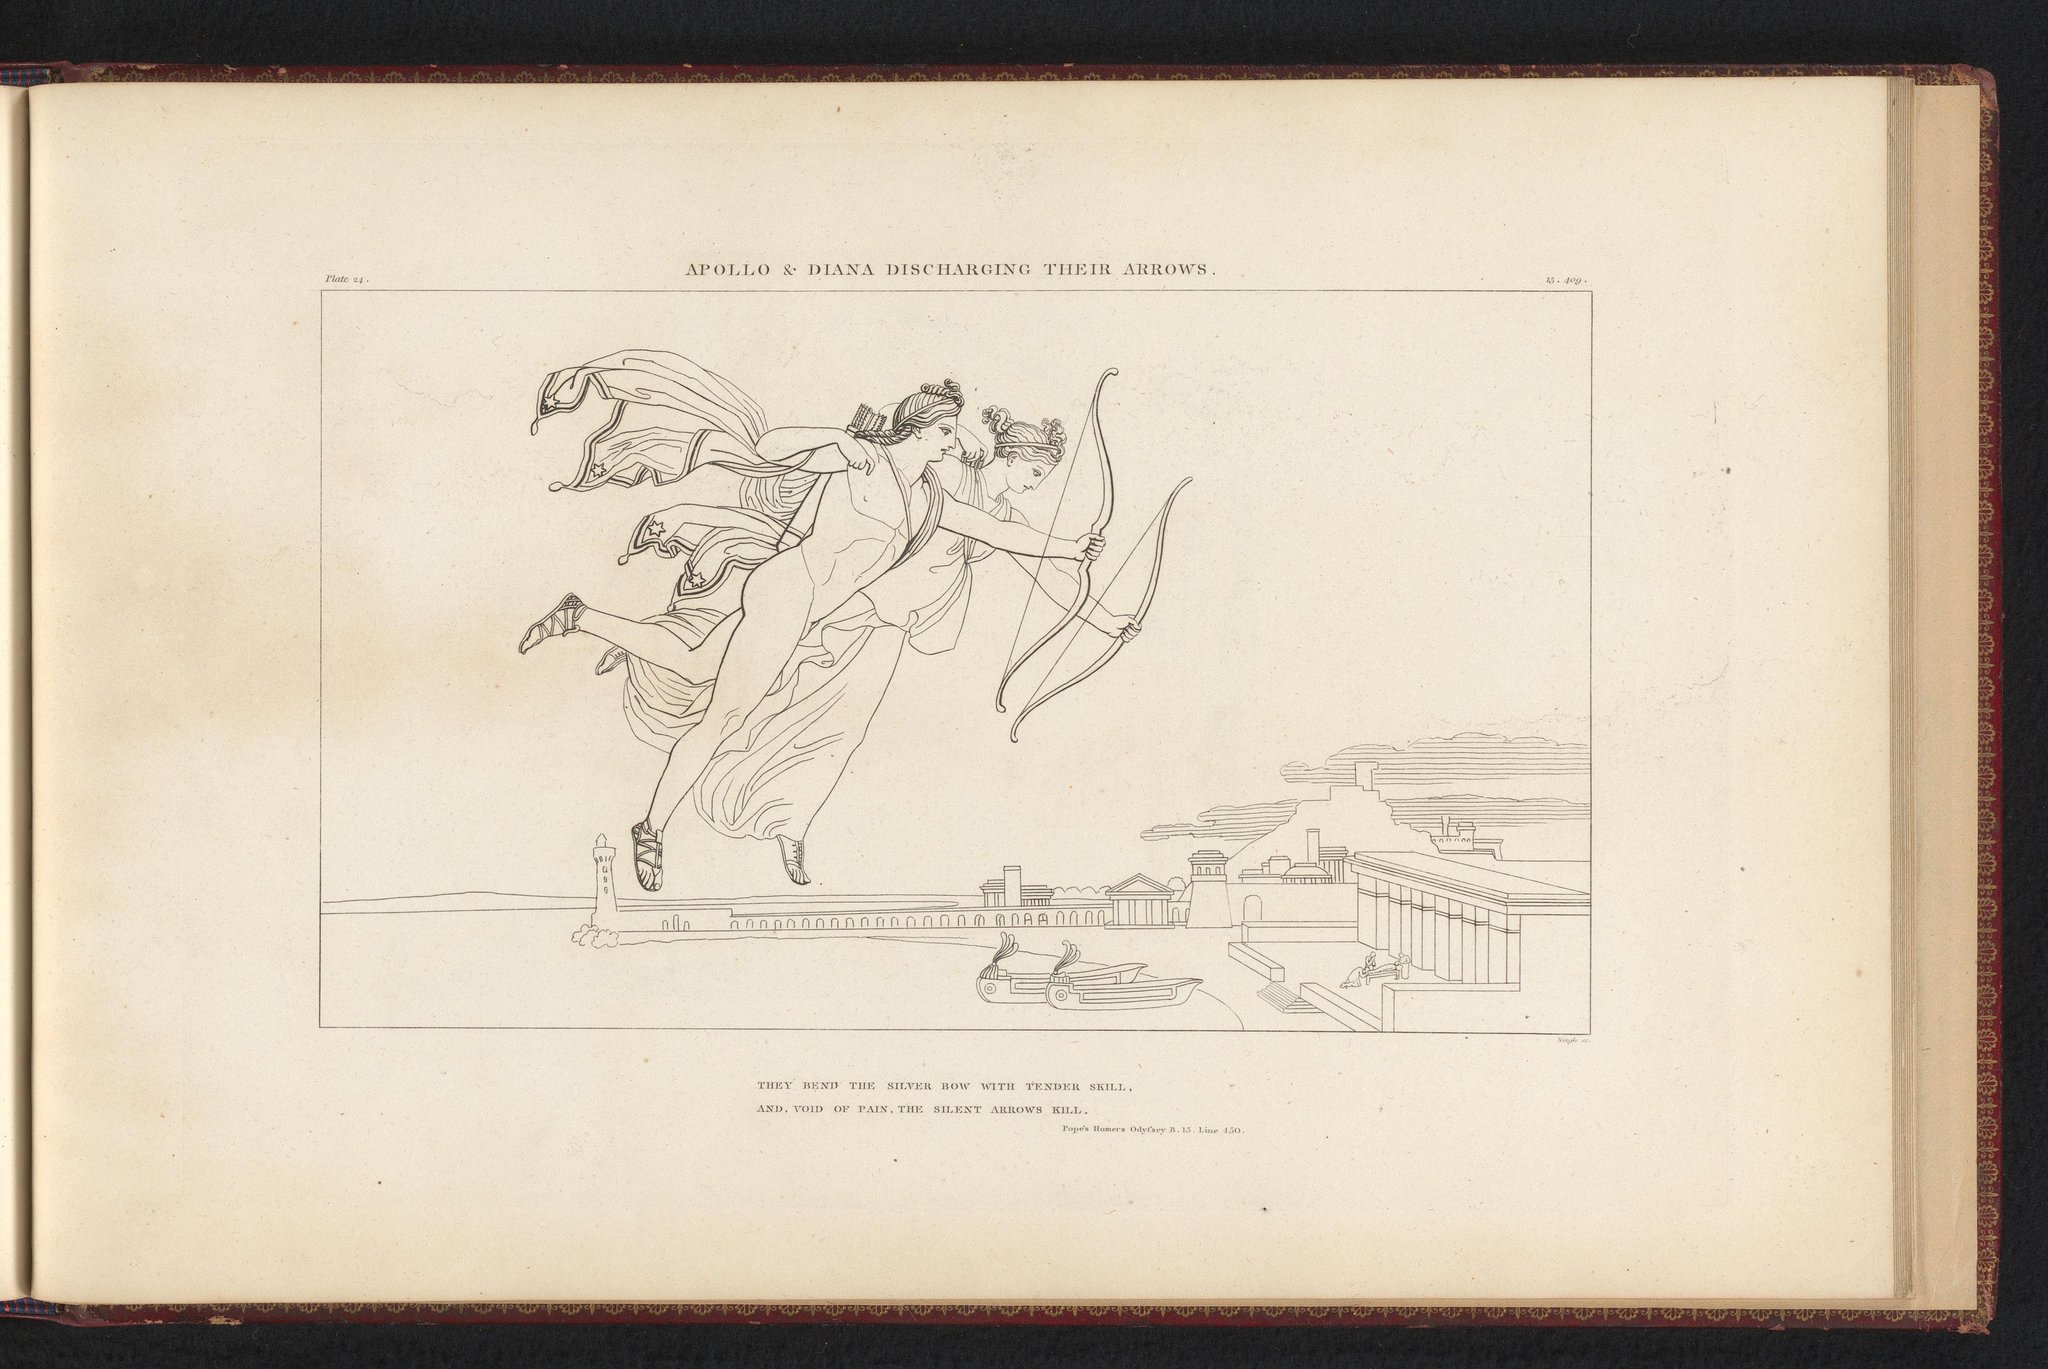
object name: album leaf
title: Odyssey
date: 1805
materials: paper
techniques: etching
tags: (story of) diana (artemis), (story of) apollo (phoebus)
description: Prent maakt onderdeel uit van een serie met 34 prenten over de Odyssee, geschreven door Homerus.